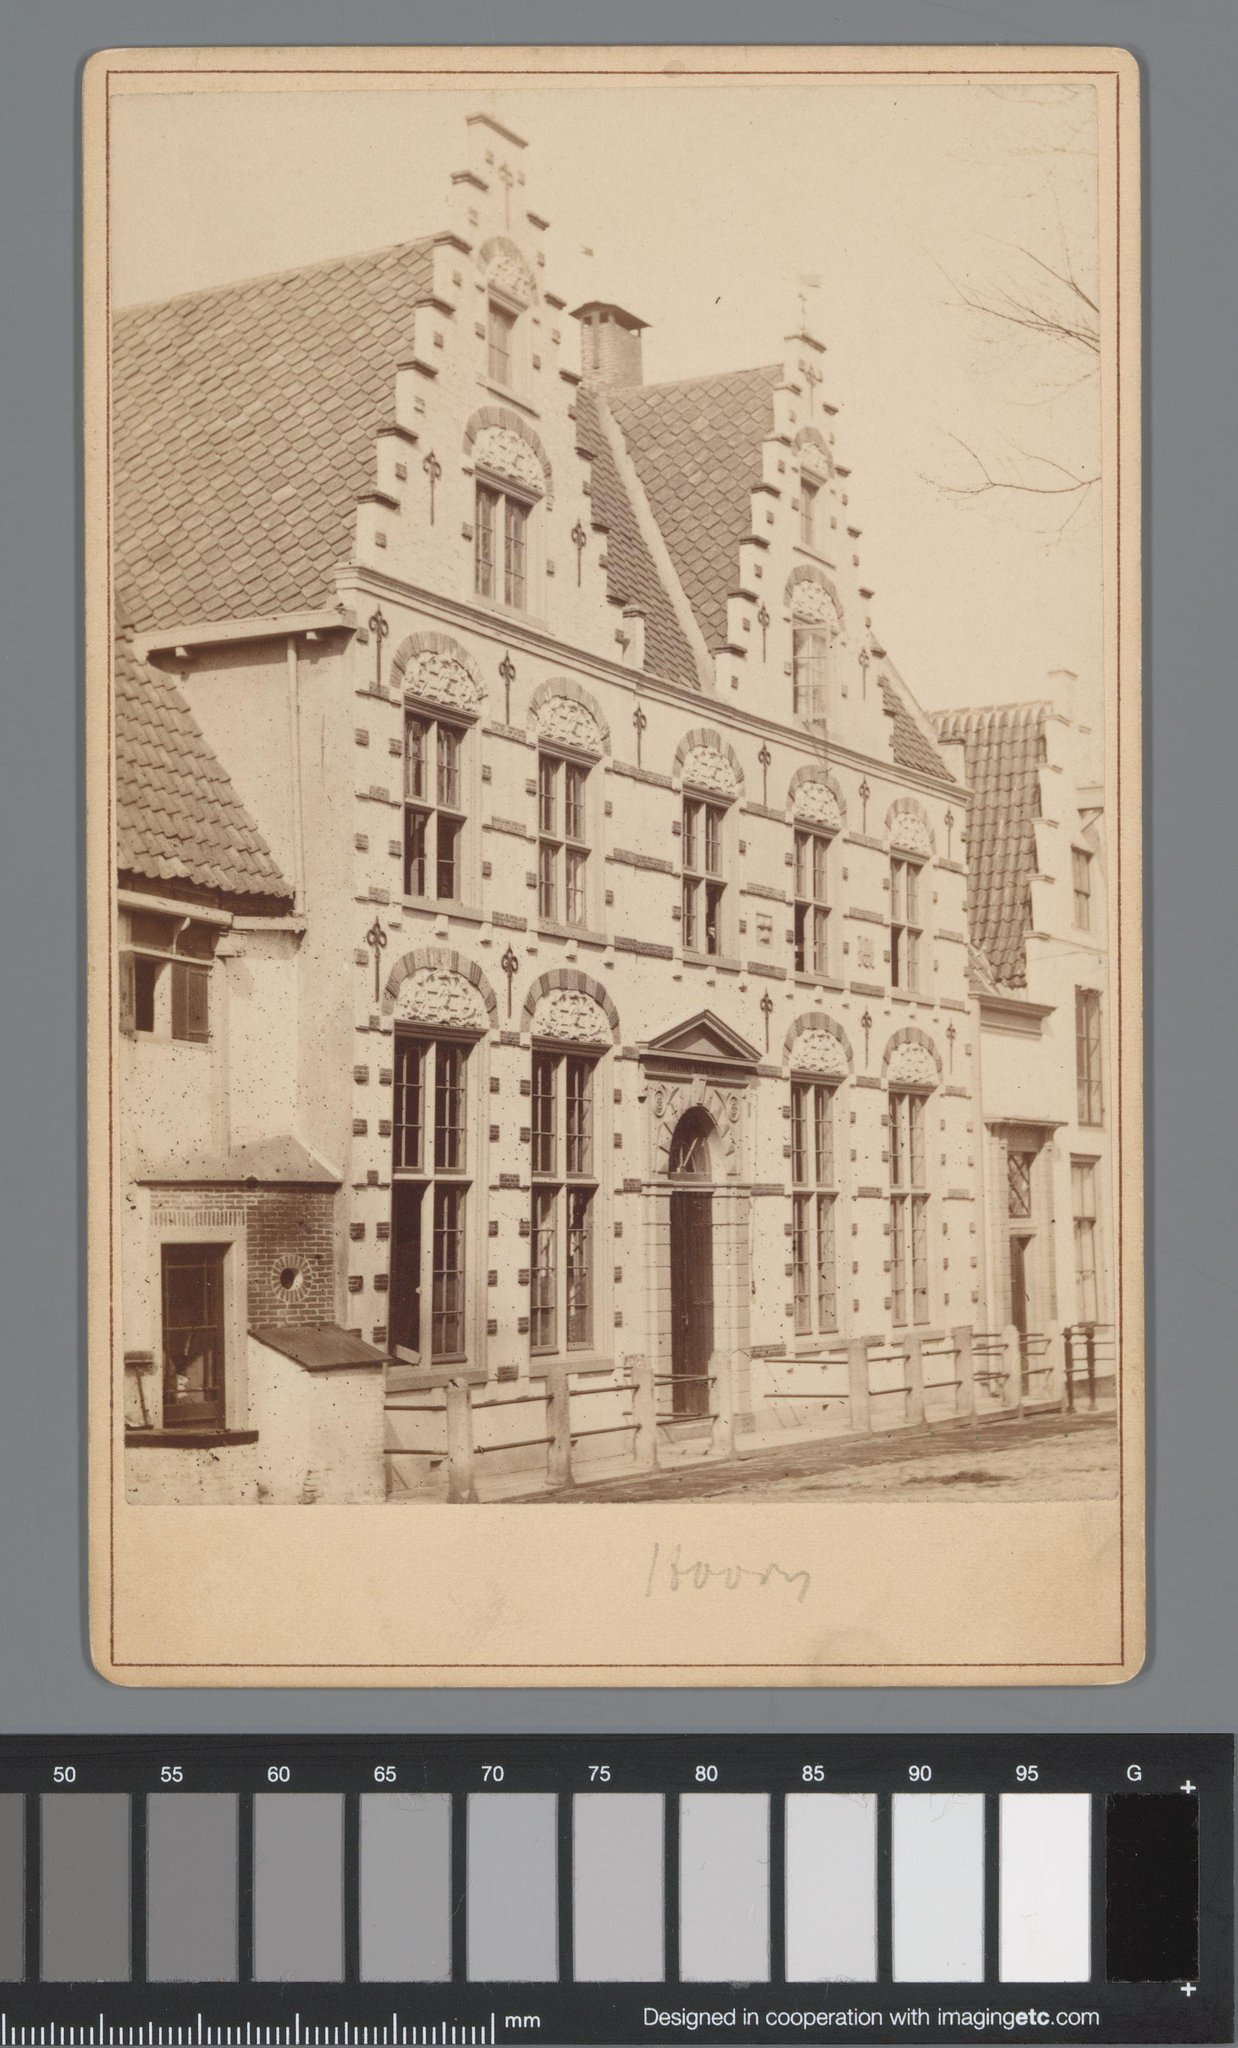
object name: photograph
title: Façade met trapgevel te Hoorn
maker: Anonymous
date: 1870-1900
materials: cardboard, photographic support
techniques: albumen print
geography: hoorn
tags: urban housing, façade (of house or building), hoorn (north holland)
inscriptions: annotation: ‘[...] huis/ VI/3 c’, annotation: ‘Hoorn’